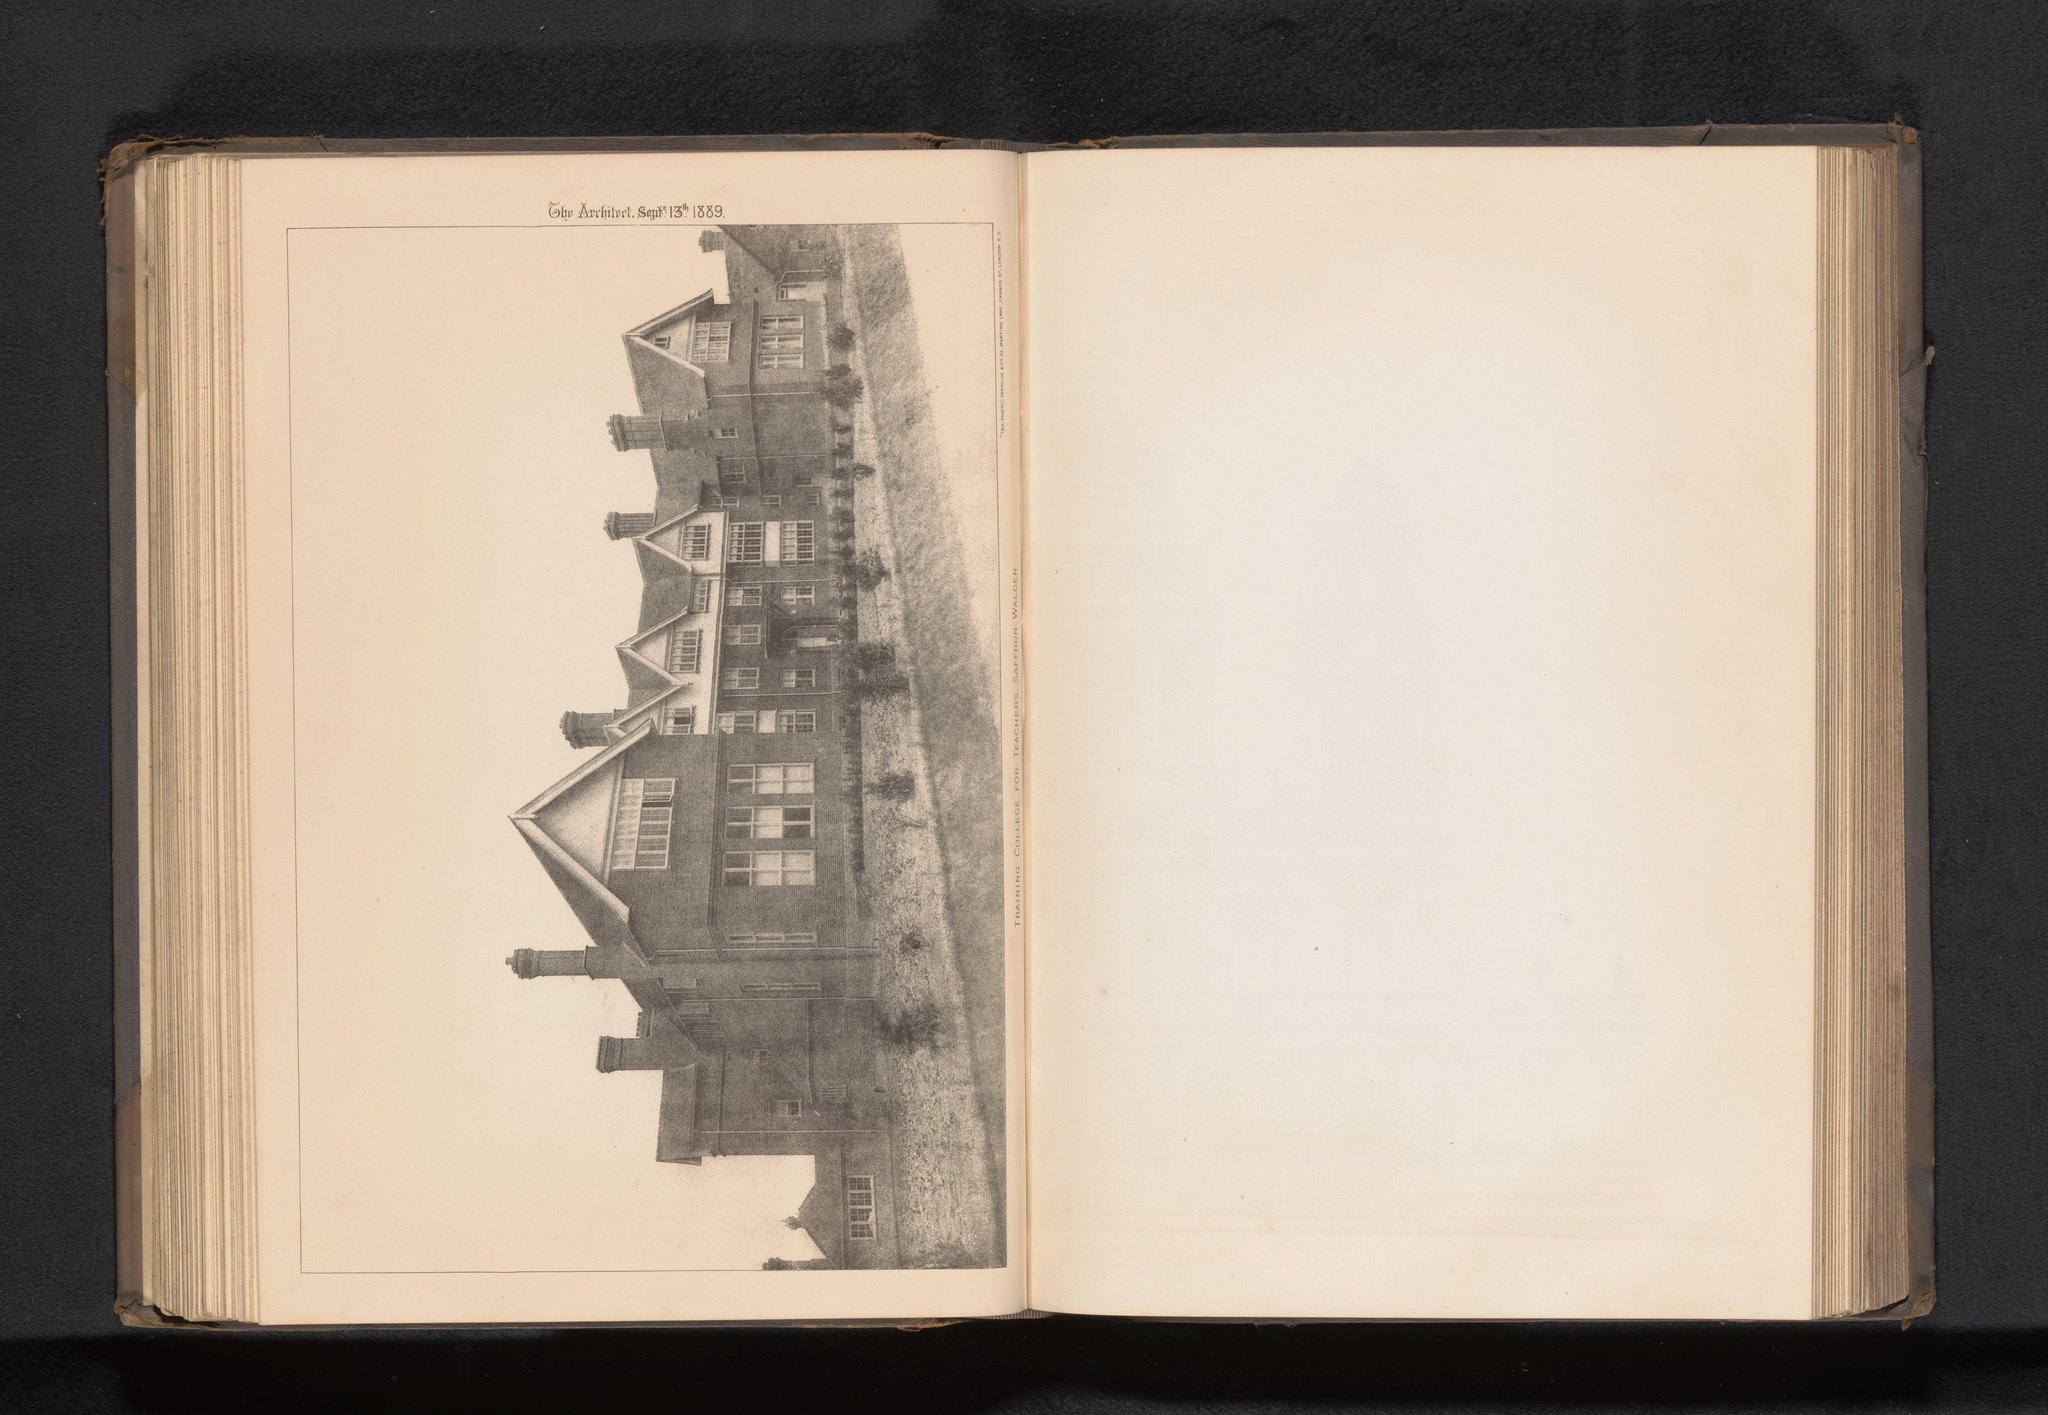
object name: photomechanical print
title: Training College for Teachers, Saffron Walden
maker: Anonymous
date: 1884-1889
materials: paper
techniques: photolithography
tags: higher education, e.g.: teacher's college, façade (of house or building)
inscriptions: inscription: ‘Edward Burgess, Architect’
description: Prent op zesde ongenummerde pagina na pagina 148.